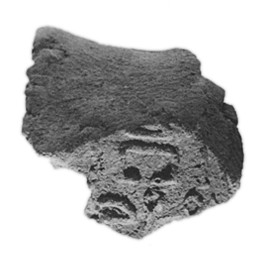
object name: sealing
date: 2030-1640 BCE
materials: clay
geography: egypt